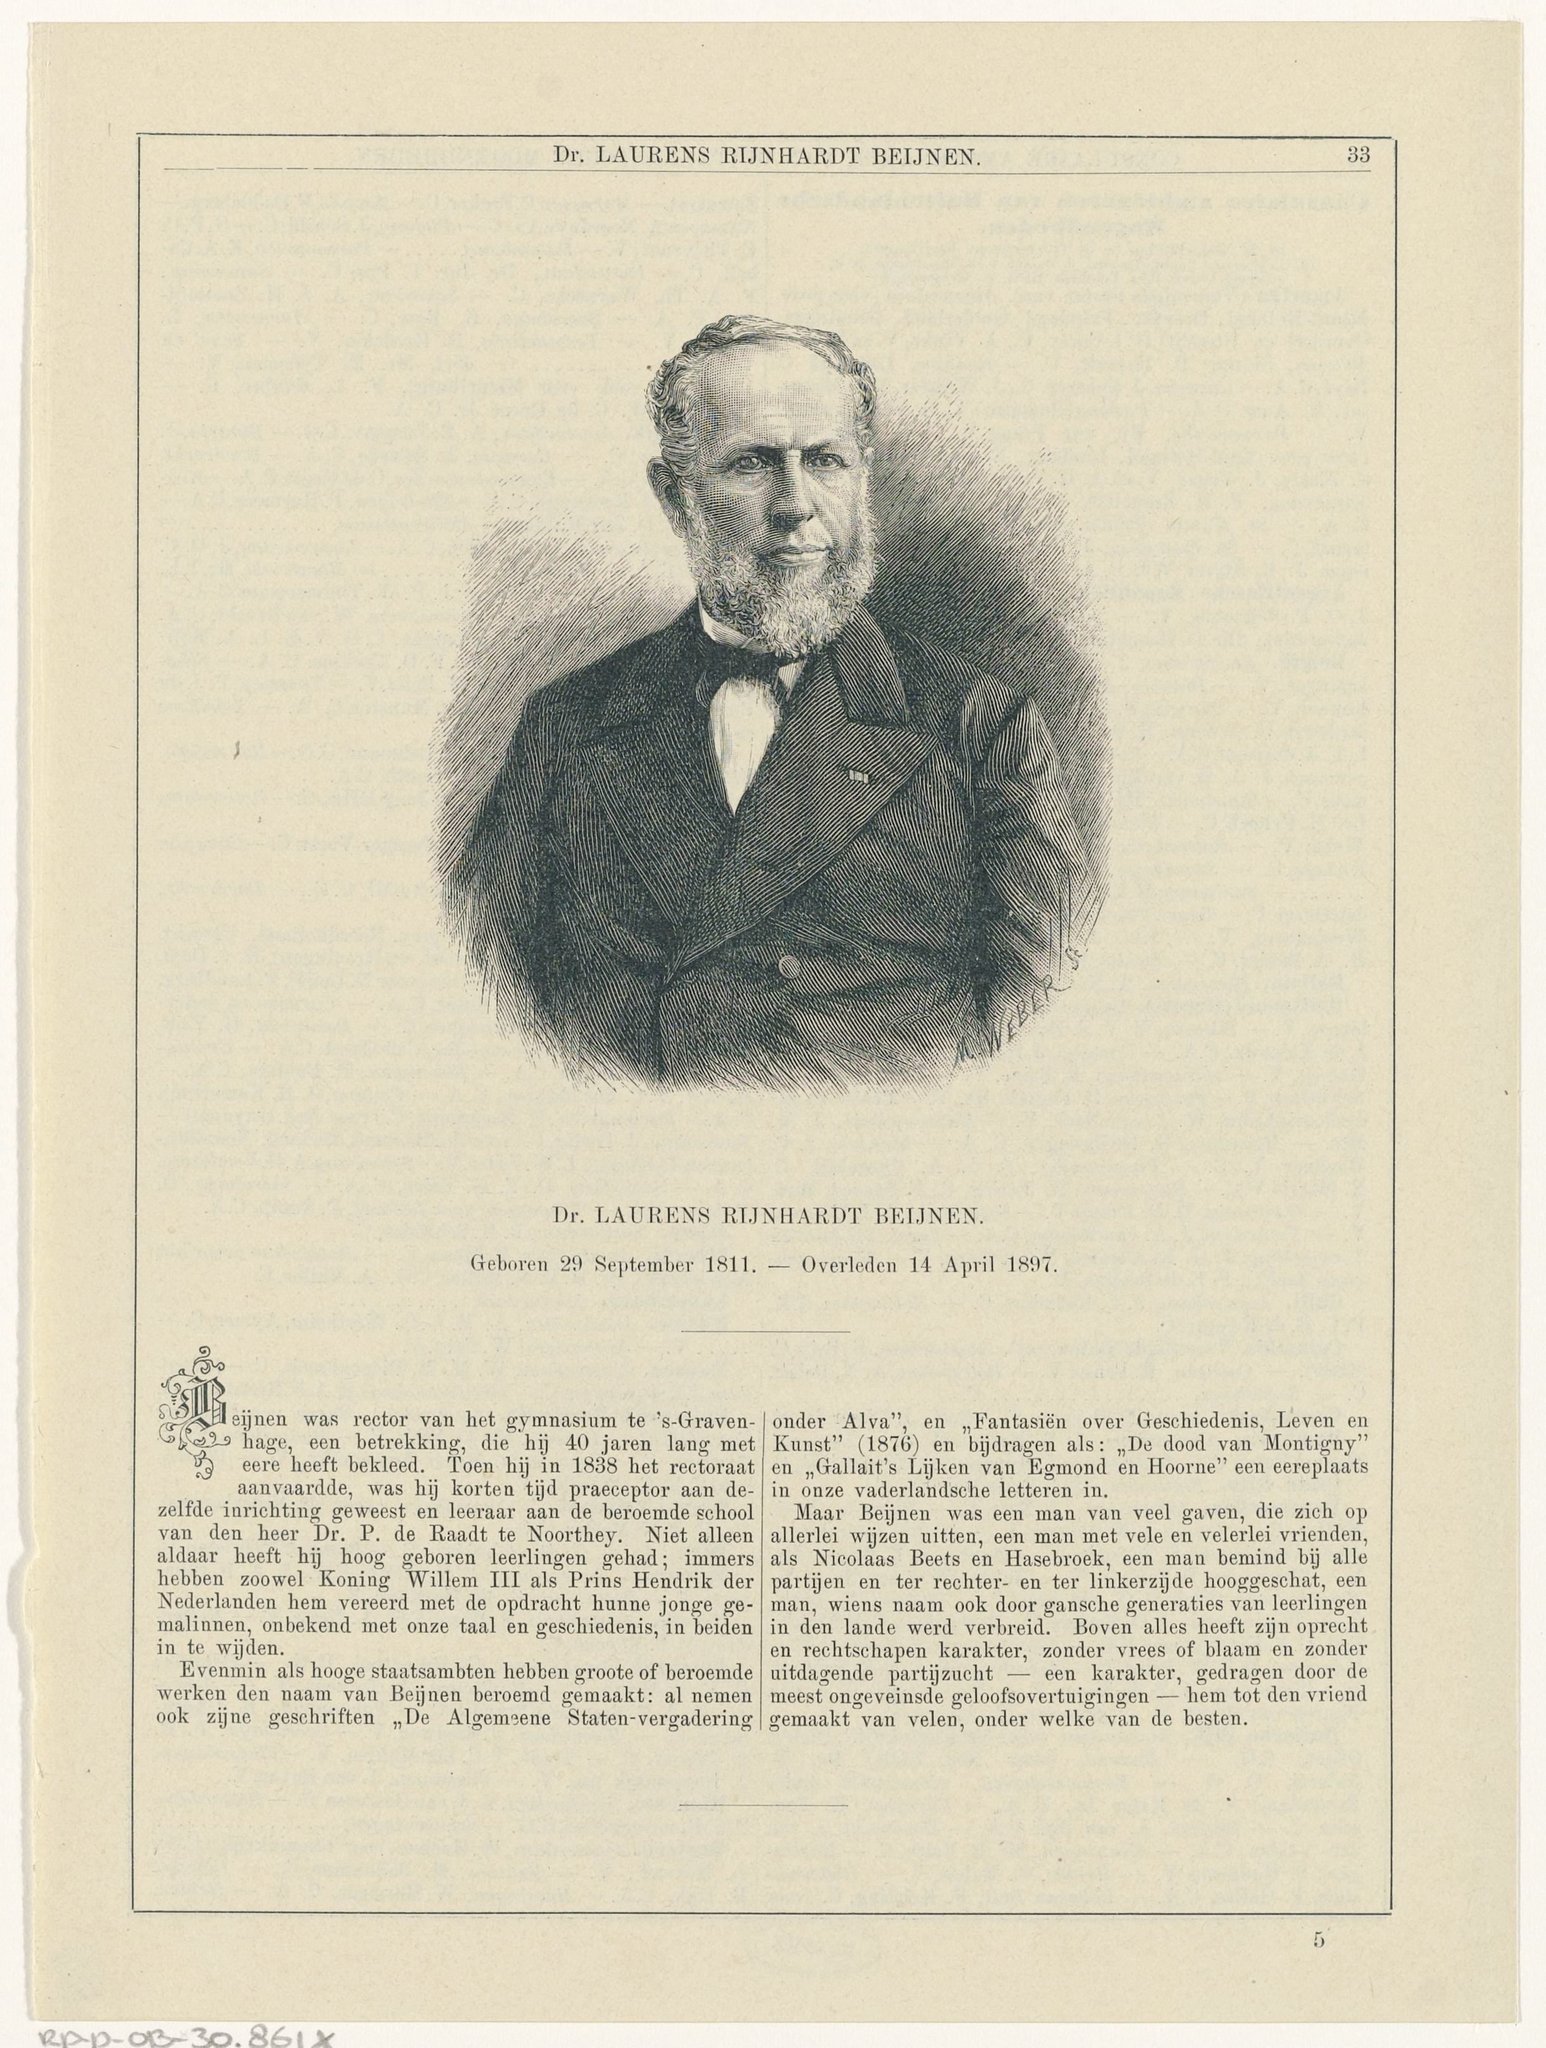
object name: book illustration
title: Portret van Laurens Rijnhardt Beijnen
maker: m. weber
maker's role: print maker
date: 1897-1899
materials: paper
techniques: letterpress printing, engraving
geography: netherlands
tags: laurens rijnhardt beijnen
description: Portret van Laurens Rijnhardt Beijnen. In de ondermarge zijn naam, zijn geboortedatum en zijn sterfdatum.